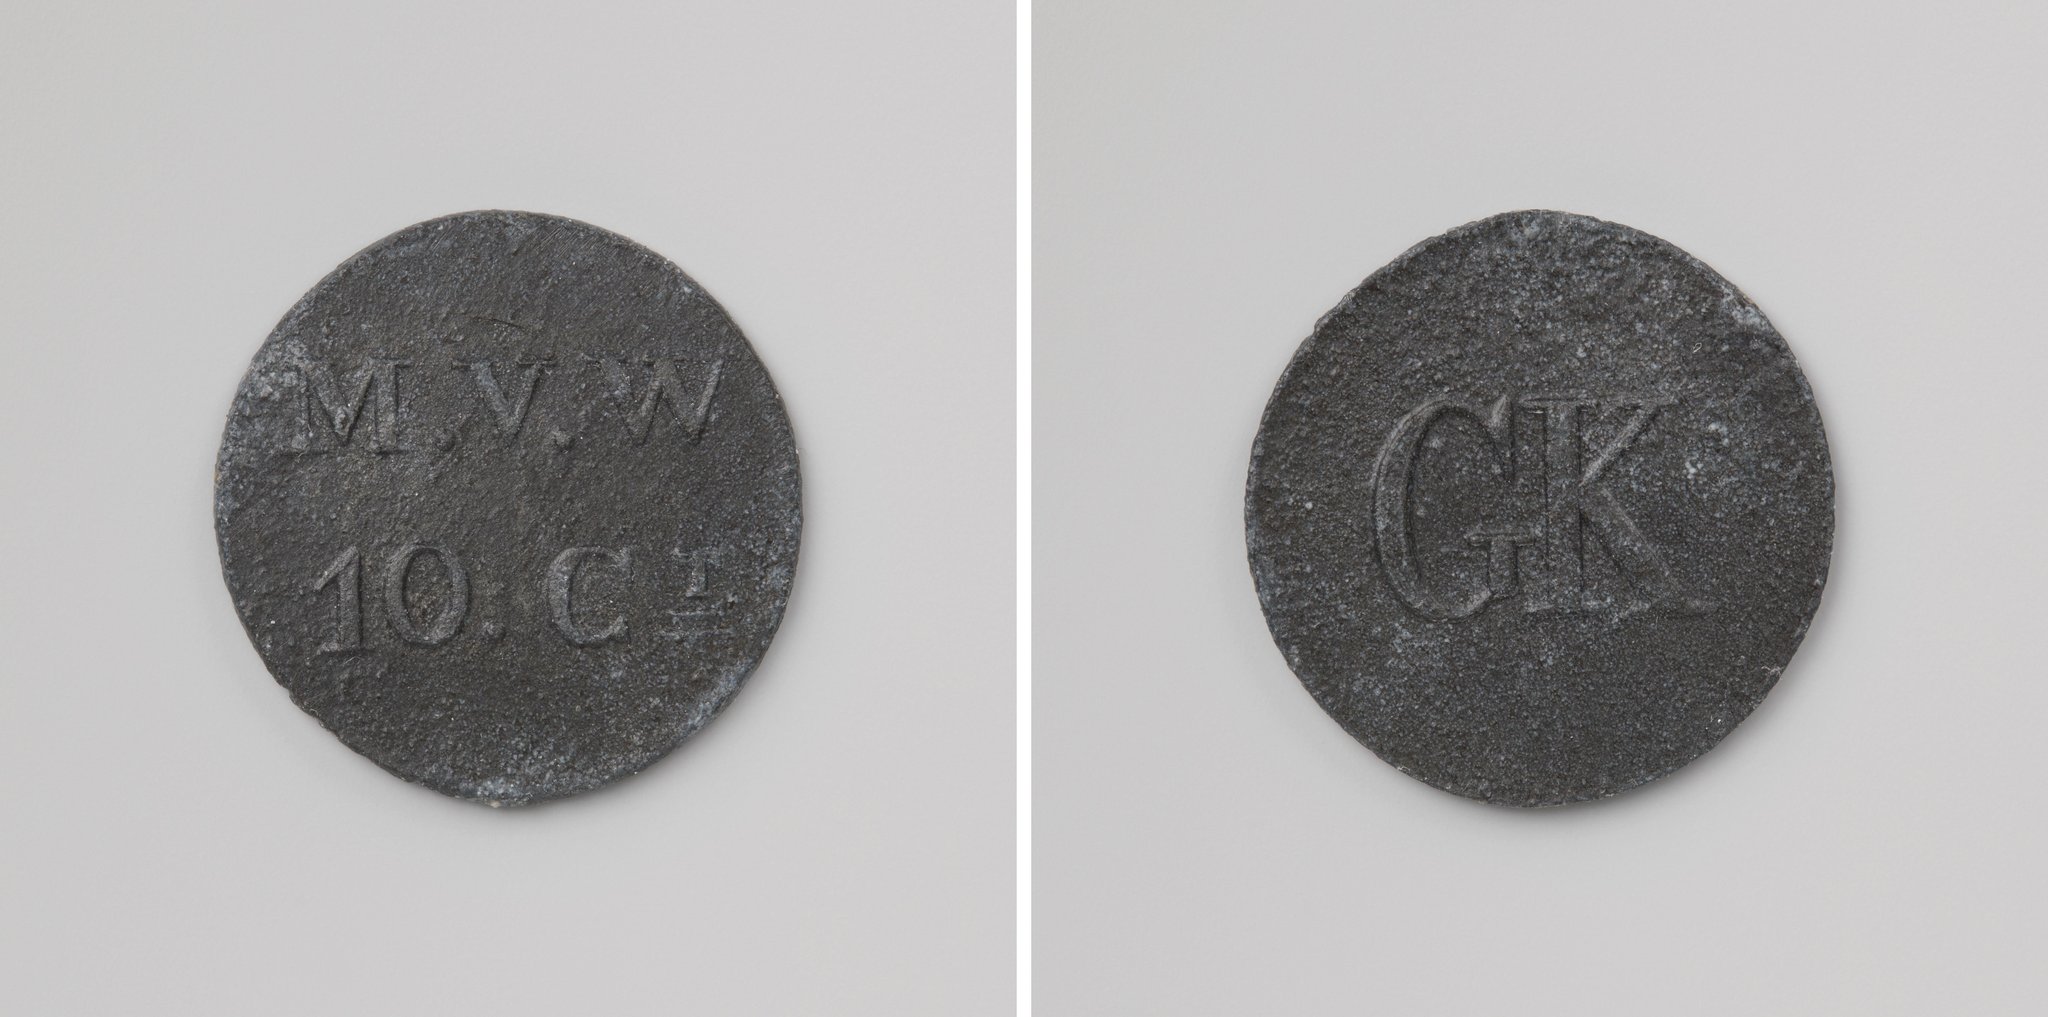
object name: tien cent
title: Huismunt geslagen op last van de Maatschappij van Weldadigheid ter waarde van tien cent, ten behoeve van de Gewone Koloniën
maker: Anonymous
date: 1818-1859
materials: zinc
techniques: striking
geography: netherlands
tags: maatschappij van weldadigheid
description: Zinken munt. Voorzijde: opschrift boven waardeaanduiding. Keerzijde: opschrift G en K